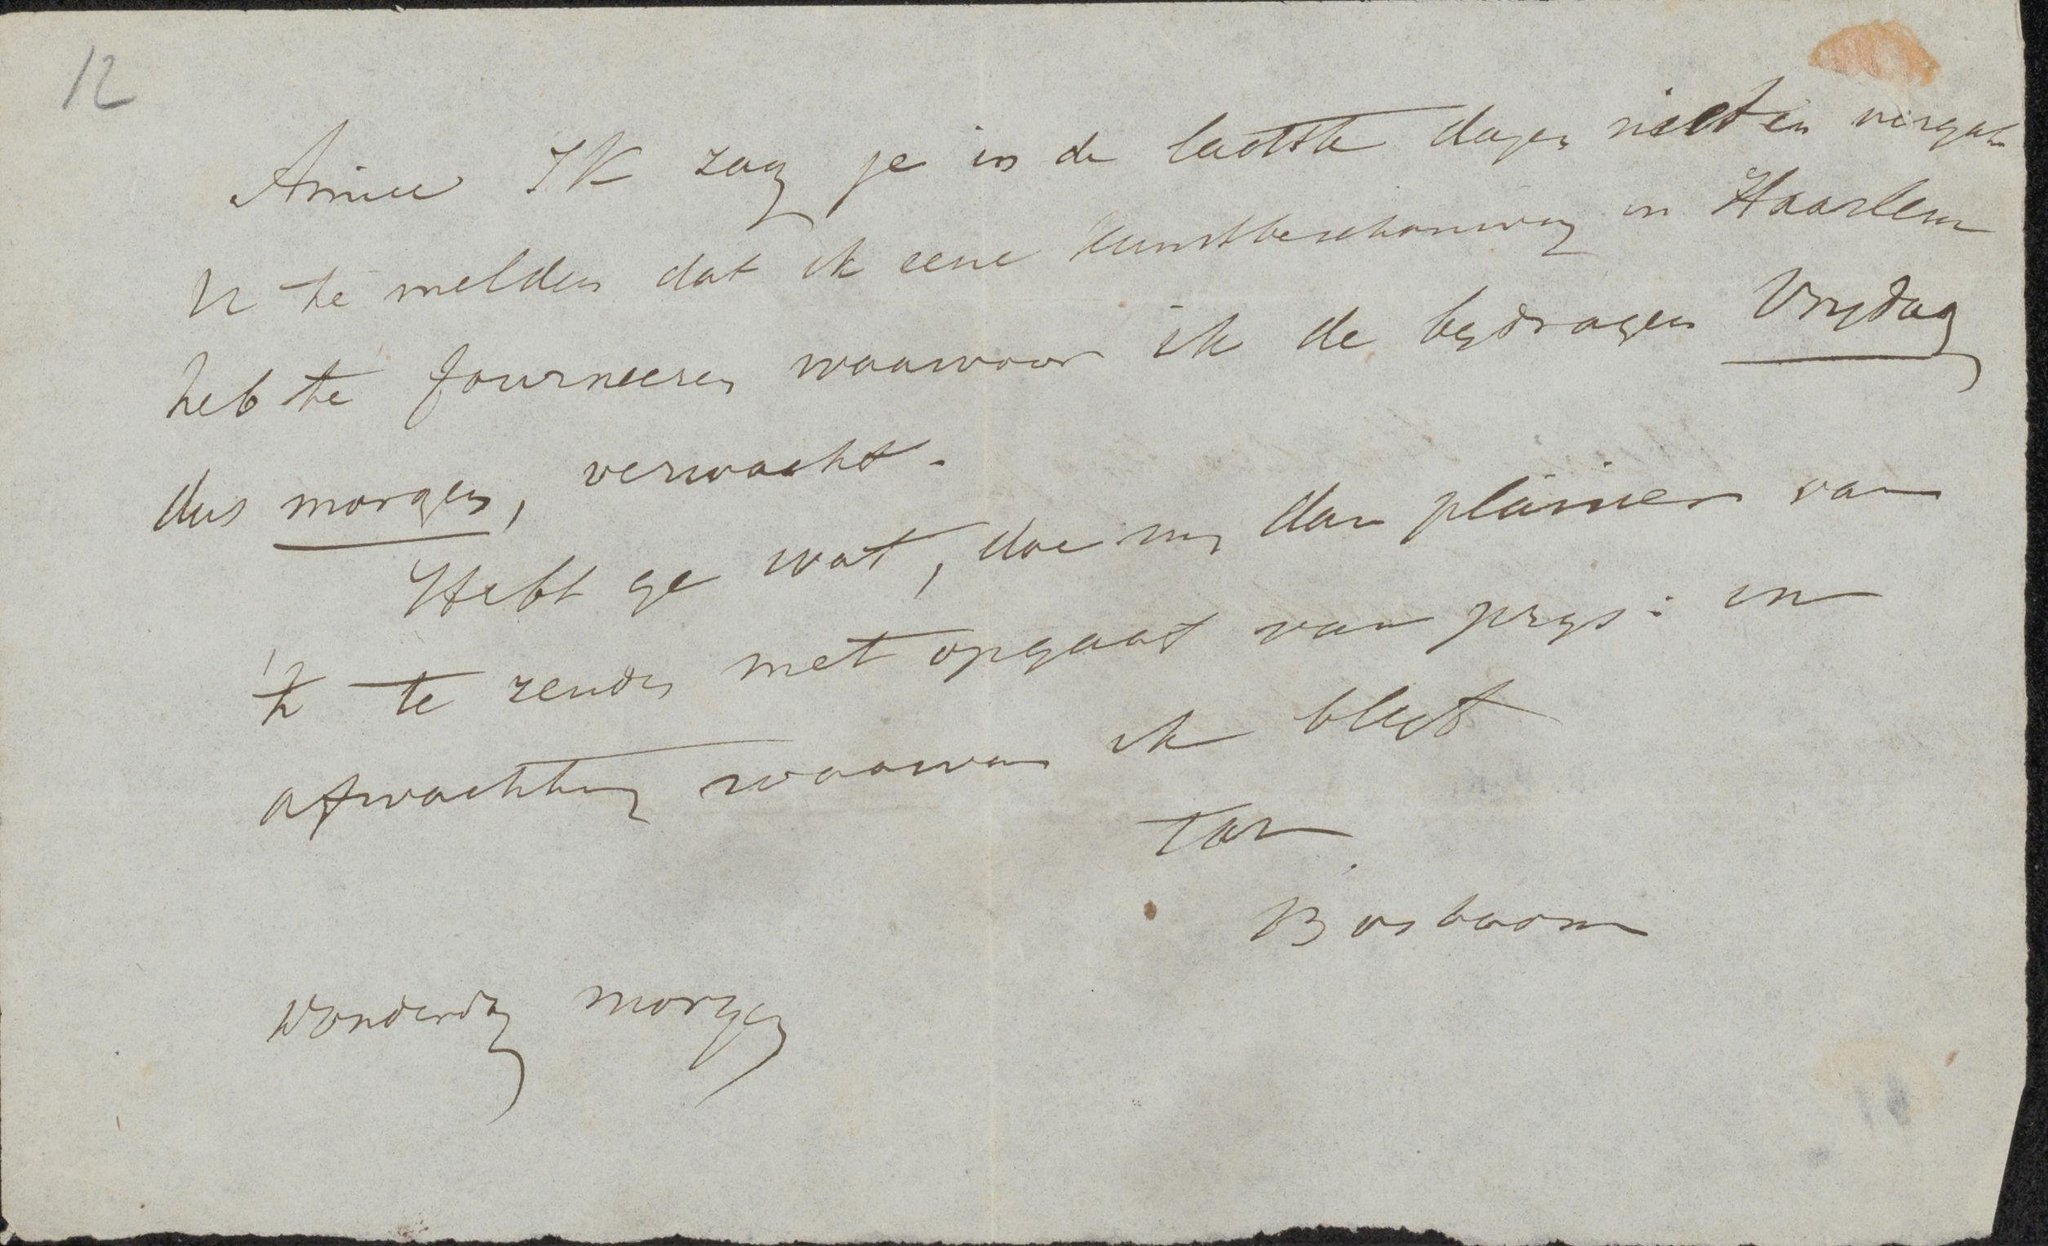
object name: letter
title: Brief aan Lambertus Hardenberg (1822-1900)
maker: johannes bosboom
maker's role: draughtsman, painter, print maker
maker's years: 1817-1891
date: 1827-1891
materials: ink, paper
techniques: pen, writing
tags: the hague, painter, print maker, draughtsman, lambertus hardenberg (1822-1900), criticizing and discussing art, art criticism, haarlem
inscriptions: collector's mark: Lugt 2233